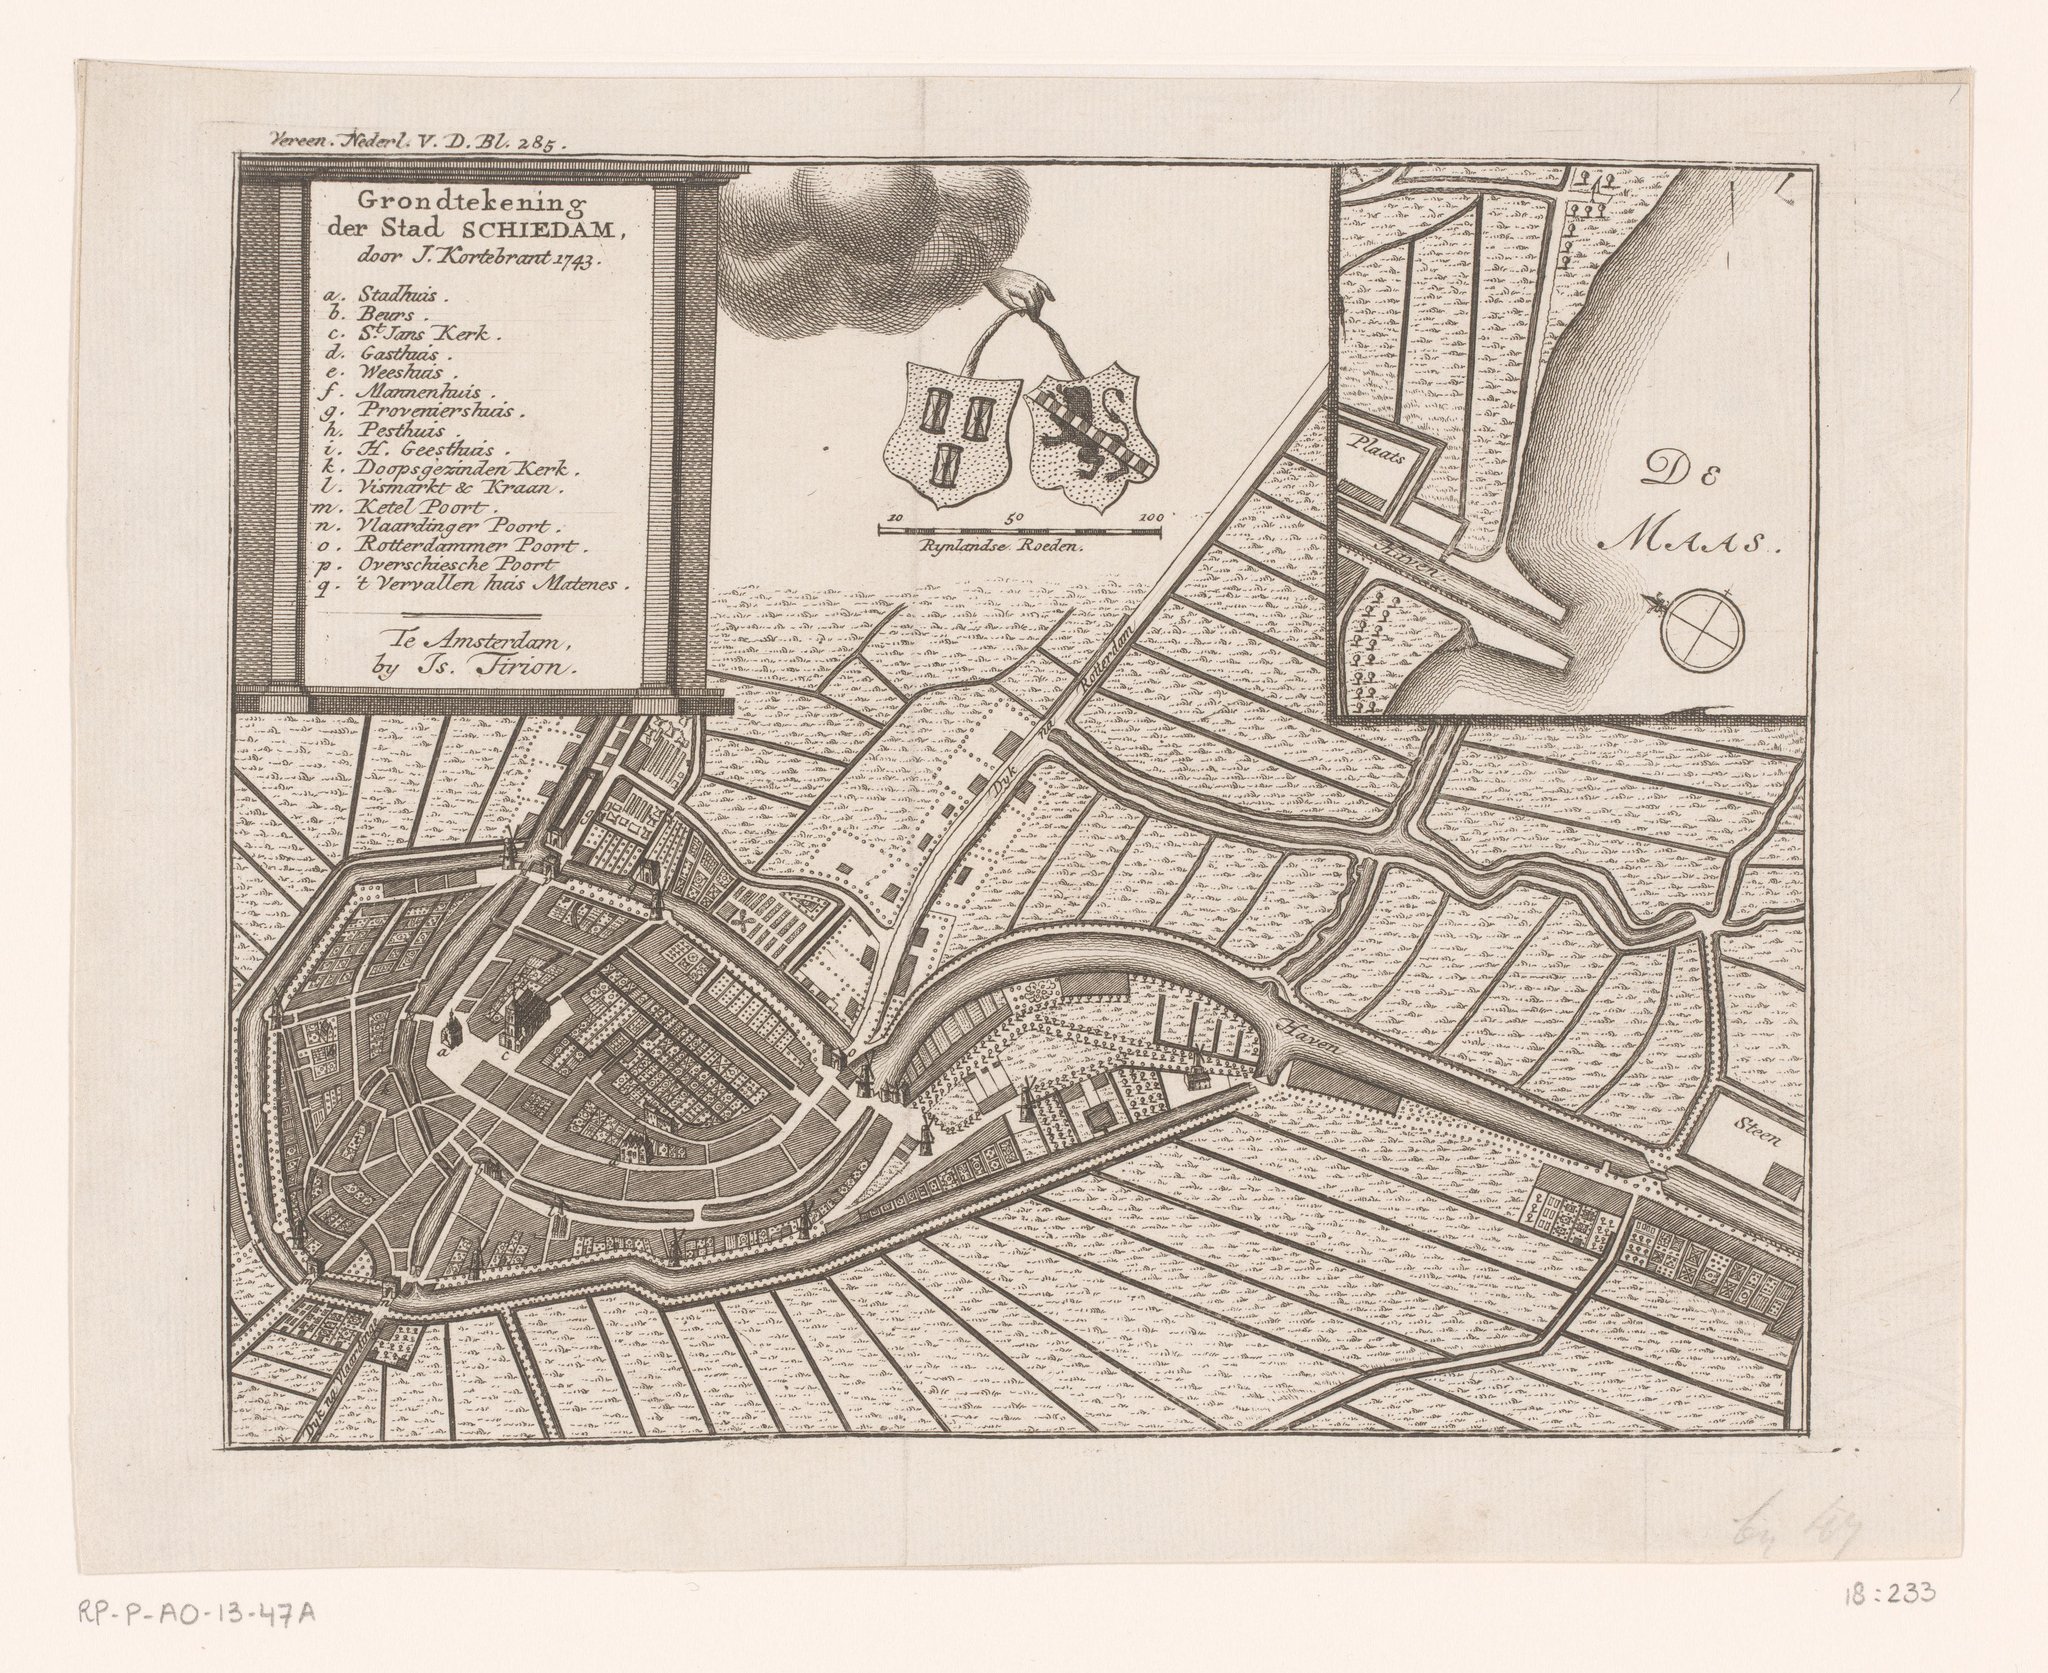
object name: print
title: Grondtekening der stad Schiedam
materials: paper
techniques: engraving, etching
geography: amsterdam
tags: coat of arms (as symbol of the state, etc.) (+ city; municipal), maps of cities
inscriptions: collector's mark: Lugt 2228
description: Prent ook gebruikt in: Wagenaar, Jan. Tegenwoordige staat der Vereenigde Nederlanden, vyfde deel. Behelzende het vervolg der beschrijvinge van Holland. Met naauwkeurige plans der steden en printverbeeldingen versierd / Hedendaagsche historie, of tegenwoordige staat van alle volkeren; XVde deel (…). Amsterdam: Isaak Tirion, 1744, tussen p. 284 en 285. En in: Beknopte atlas, van omtrent honderd platte gronden der voornaamste vestingen, kasteelen en steden van Europa, en byzonder van de Nederlanden en eenige kolonien (…). Amsterdam: Compagnie van Boekverkopers, s.a. [na 1780].